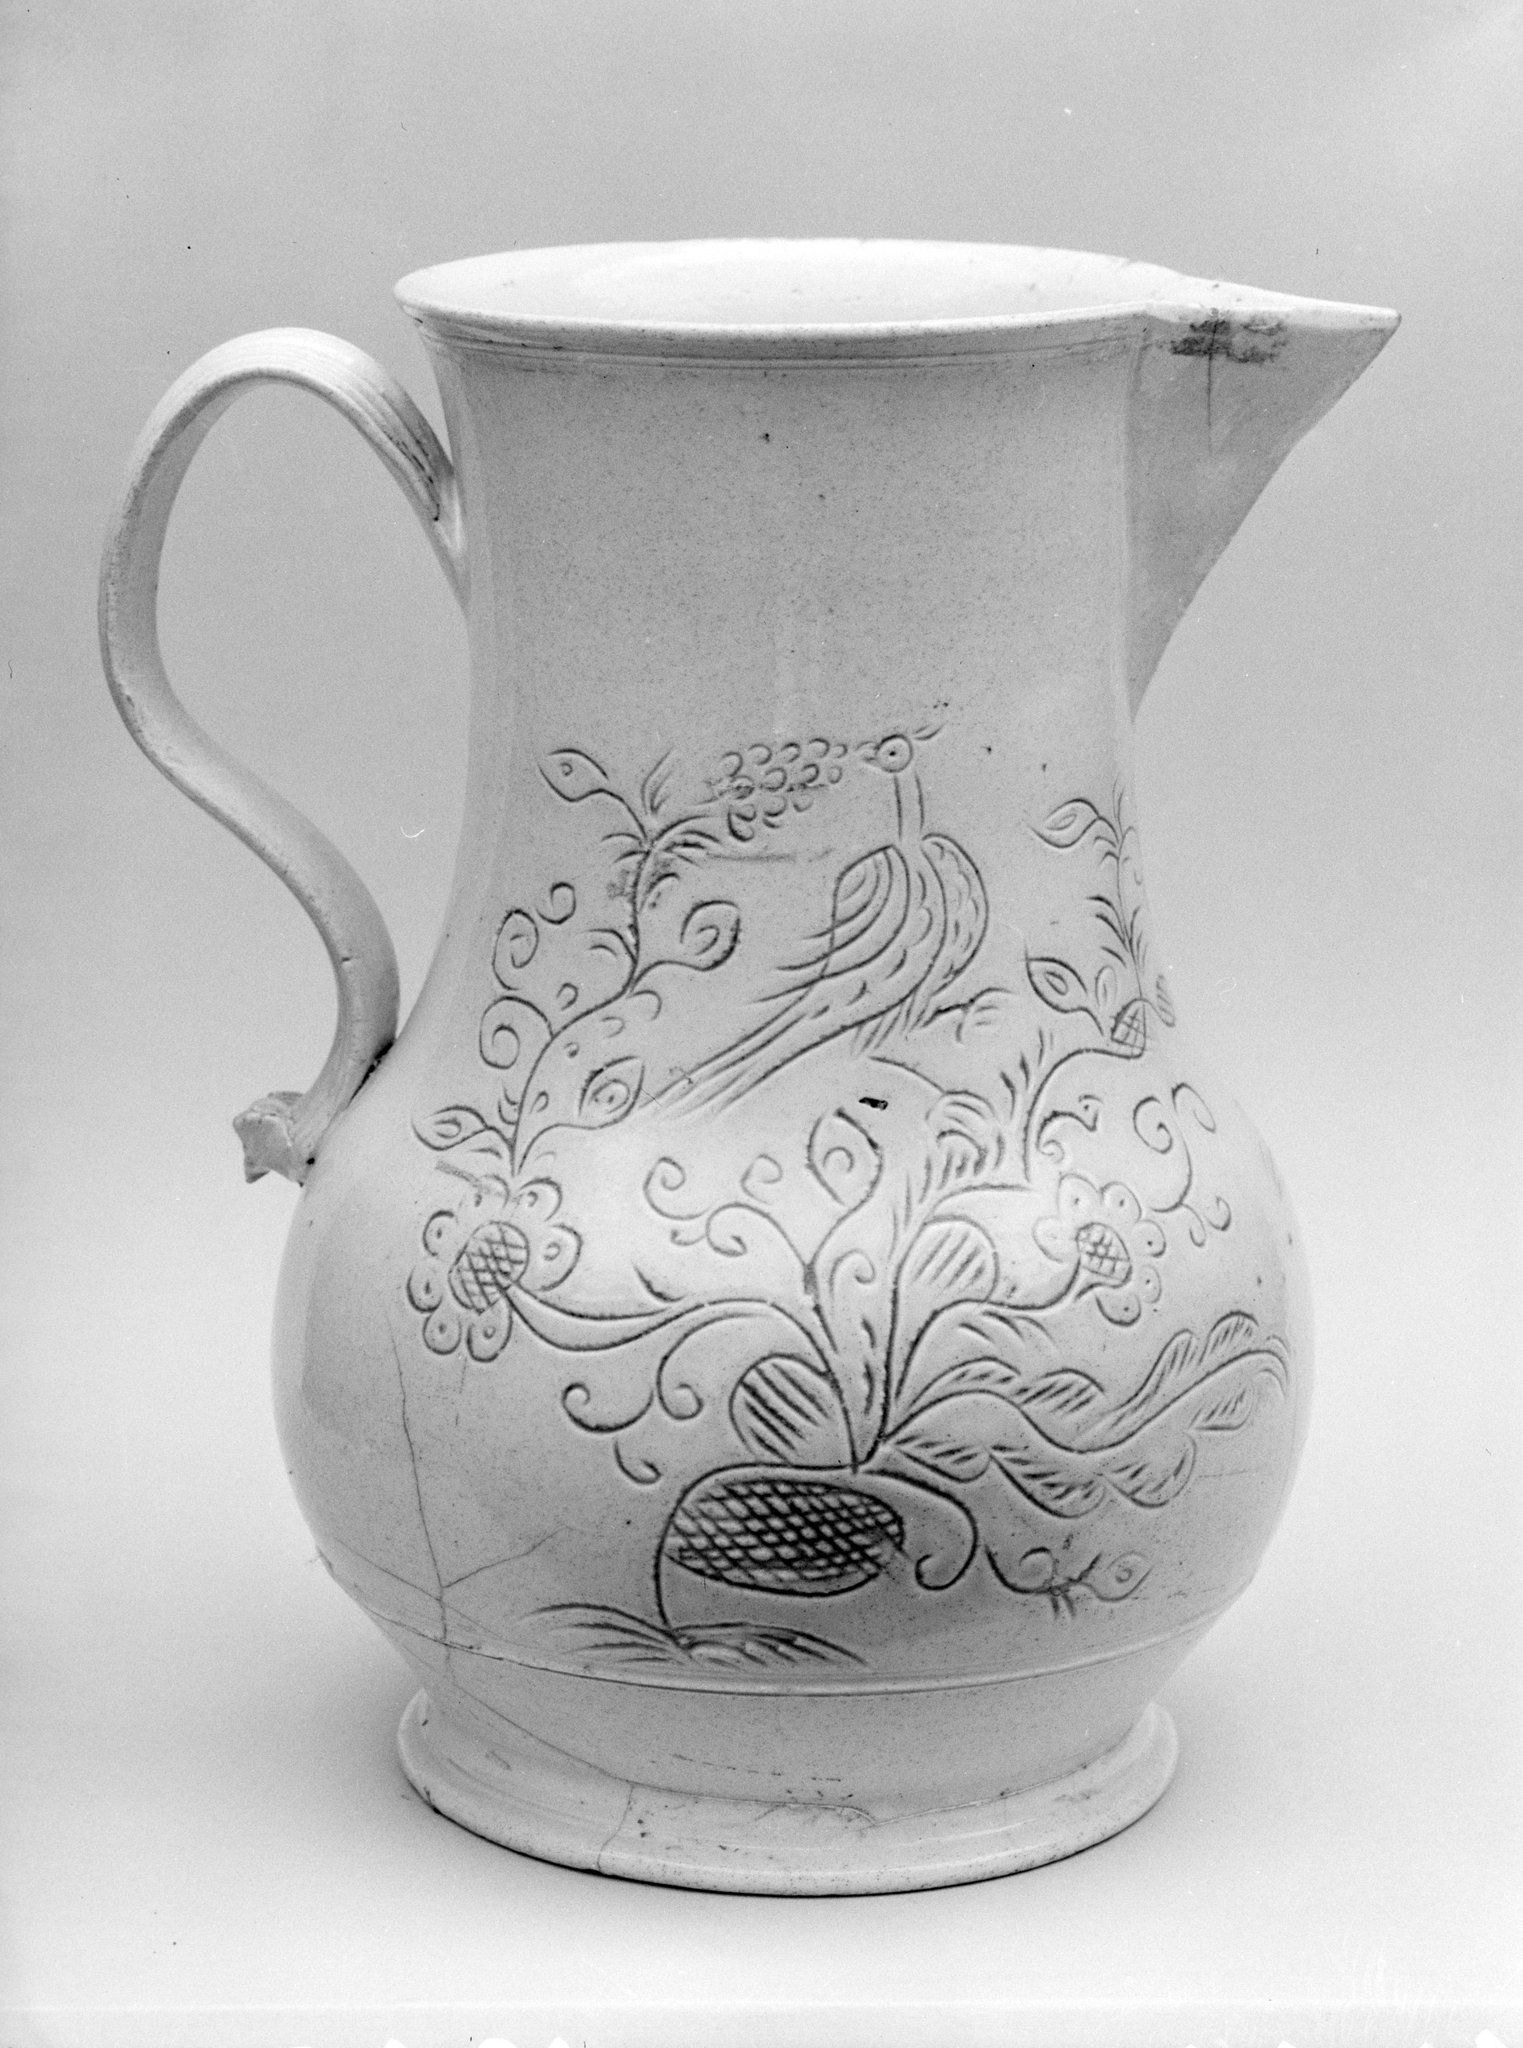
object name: pitcher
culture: british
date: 1750-1760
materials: stoneware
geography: england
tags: birds,flowers